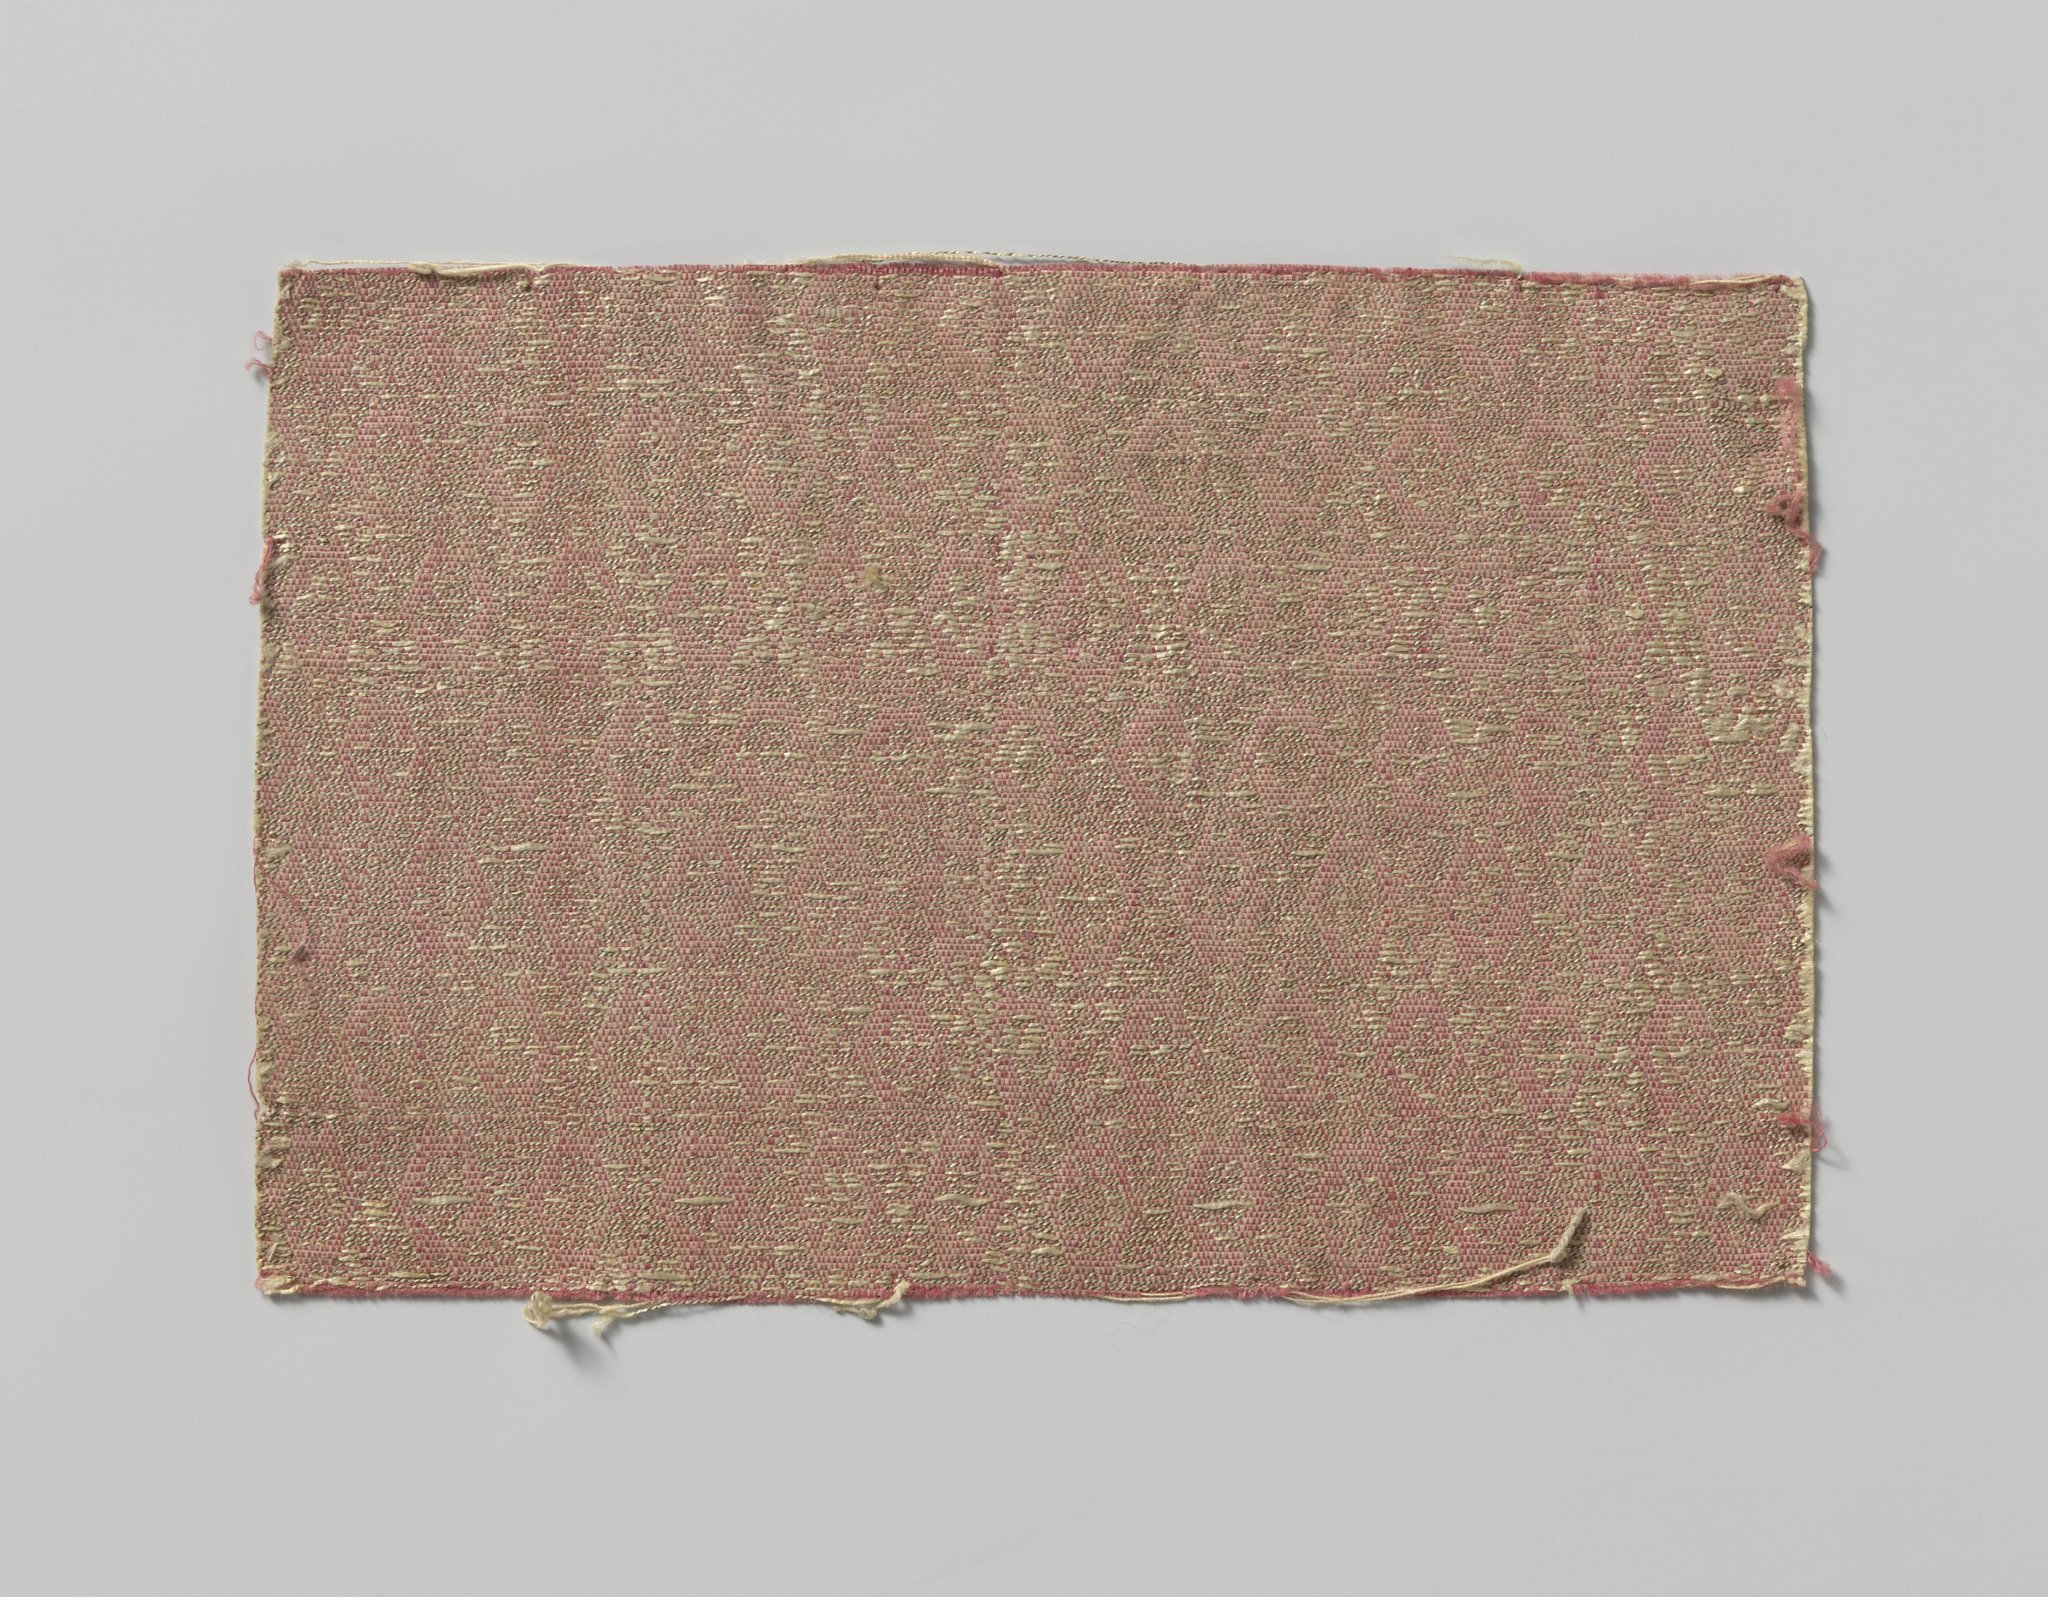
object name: silk textile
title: Fragment oosterse textiel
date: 1800-1850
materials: cotton, silk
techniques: weave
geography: india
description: Fragment oosterse textiel van wit en goud op rood. Het patroon heeft een netwerk van ruitvormige velden waarin een ornament.